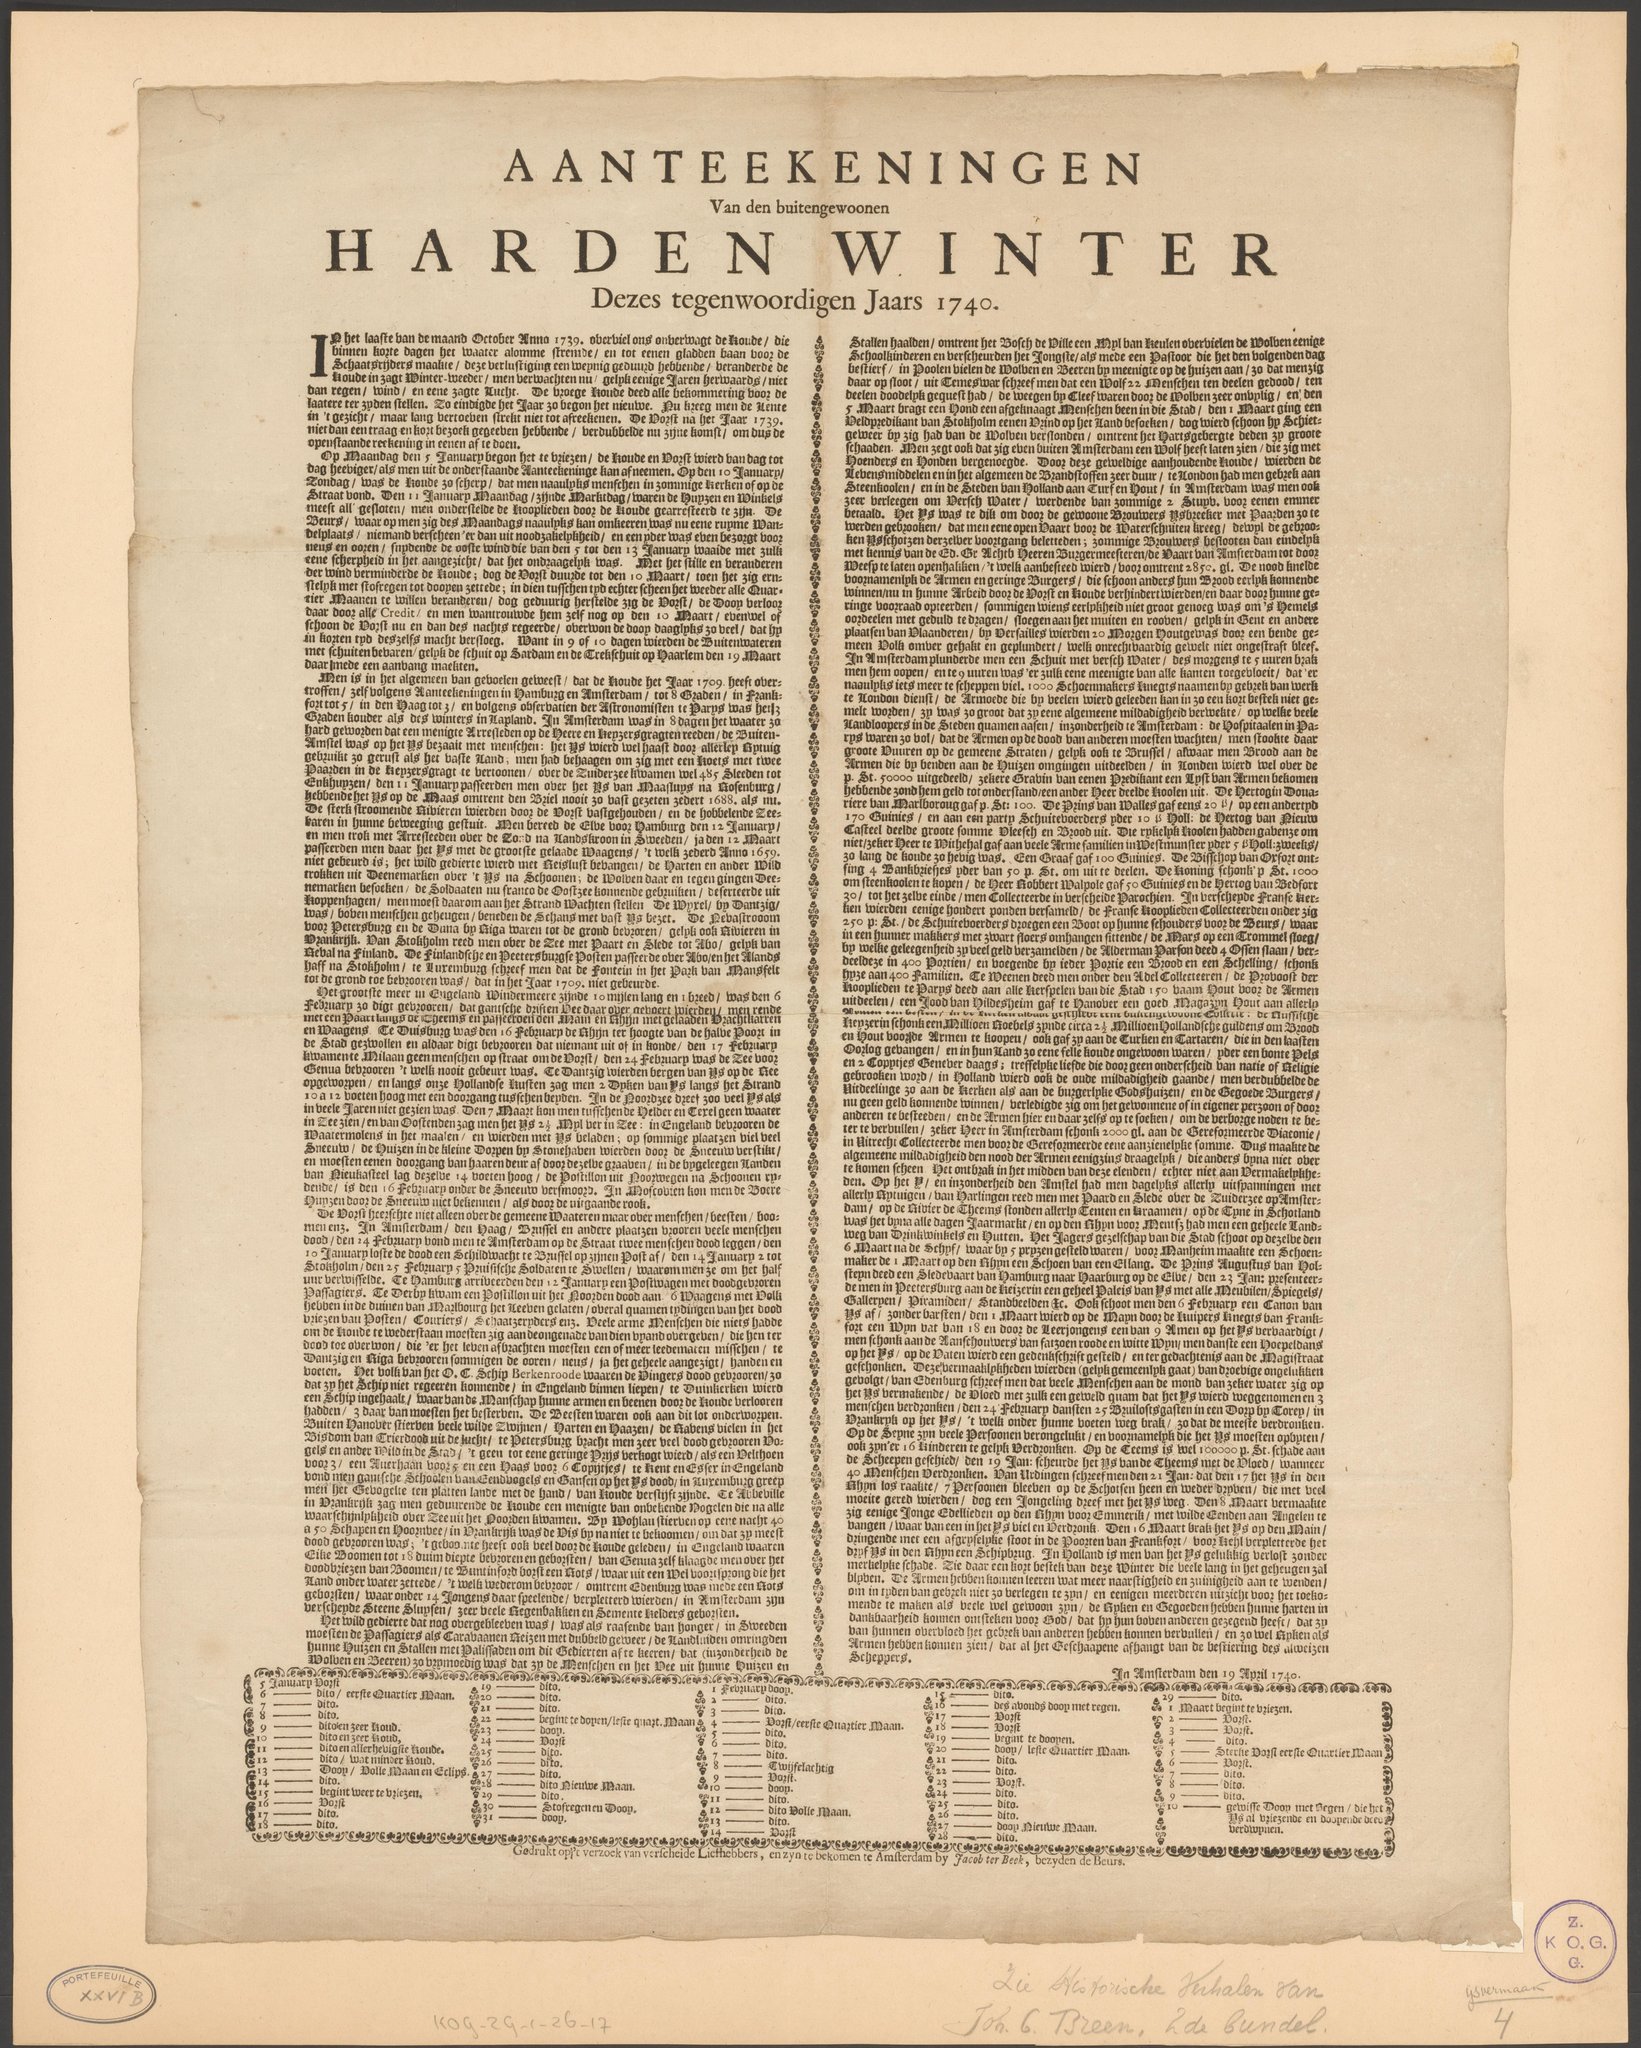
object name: text sheet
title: Aanteekeningen van den buitengewoonen Harden Winter dezes tegenwoordigen jaars 1740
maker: jacob ter beek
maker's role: publisher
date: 1704-1740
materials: paper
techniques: letterpress printing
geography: amsterdam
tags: severe winters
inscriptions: collector's mark: Lugt 1641, collector's mark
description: Tekstblad met in twee kolommen een beschrijving van de strenge winter van januari-maart 1740. De tekst gedateerd 19 april 1740. Plano in staand formaat met langere tekst. Onderwerpsrubrieken binnen de Atlas Zeden en Gewoonten: Spel en Vermaak; IJsvermaak, Strenge winters.